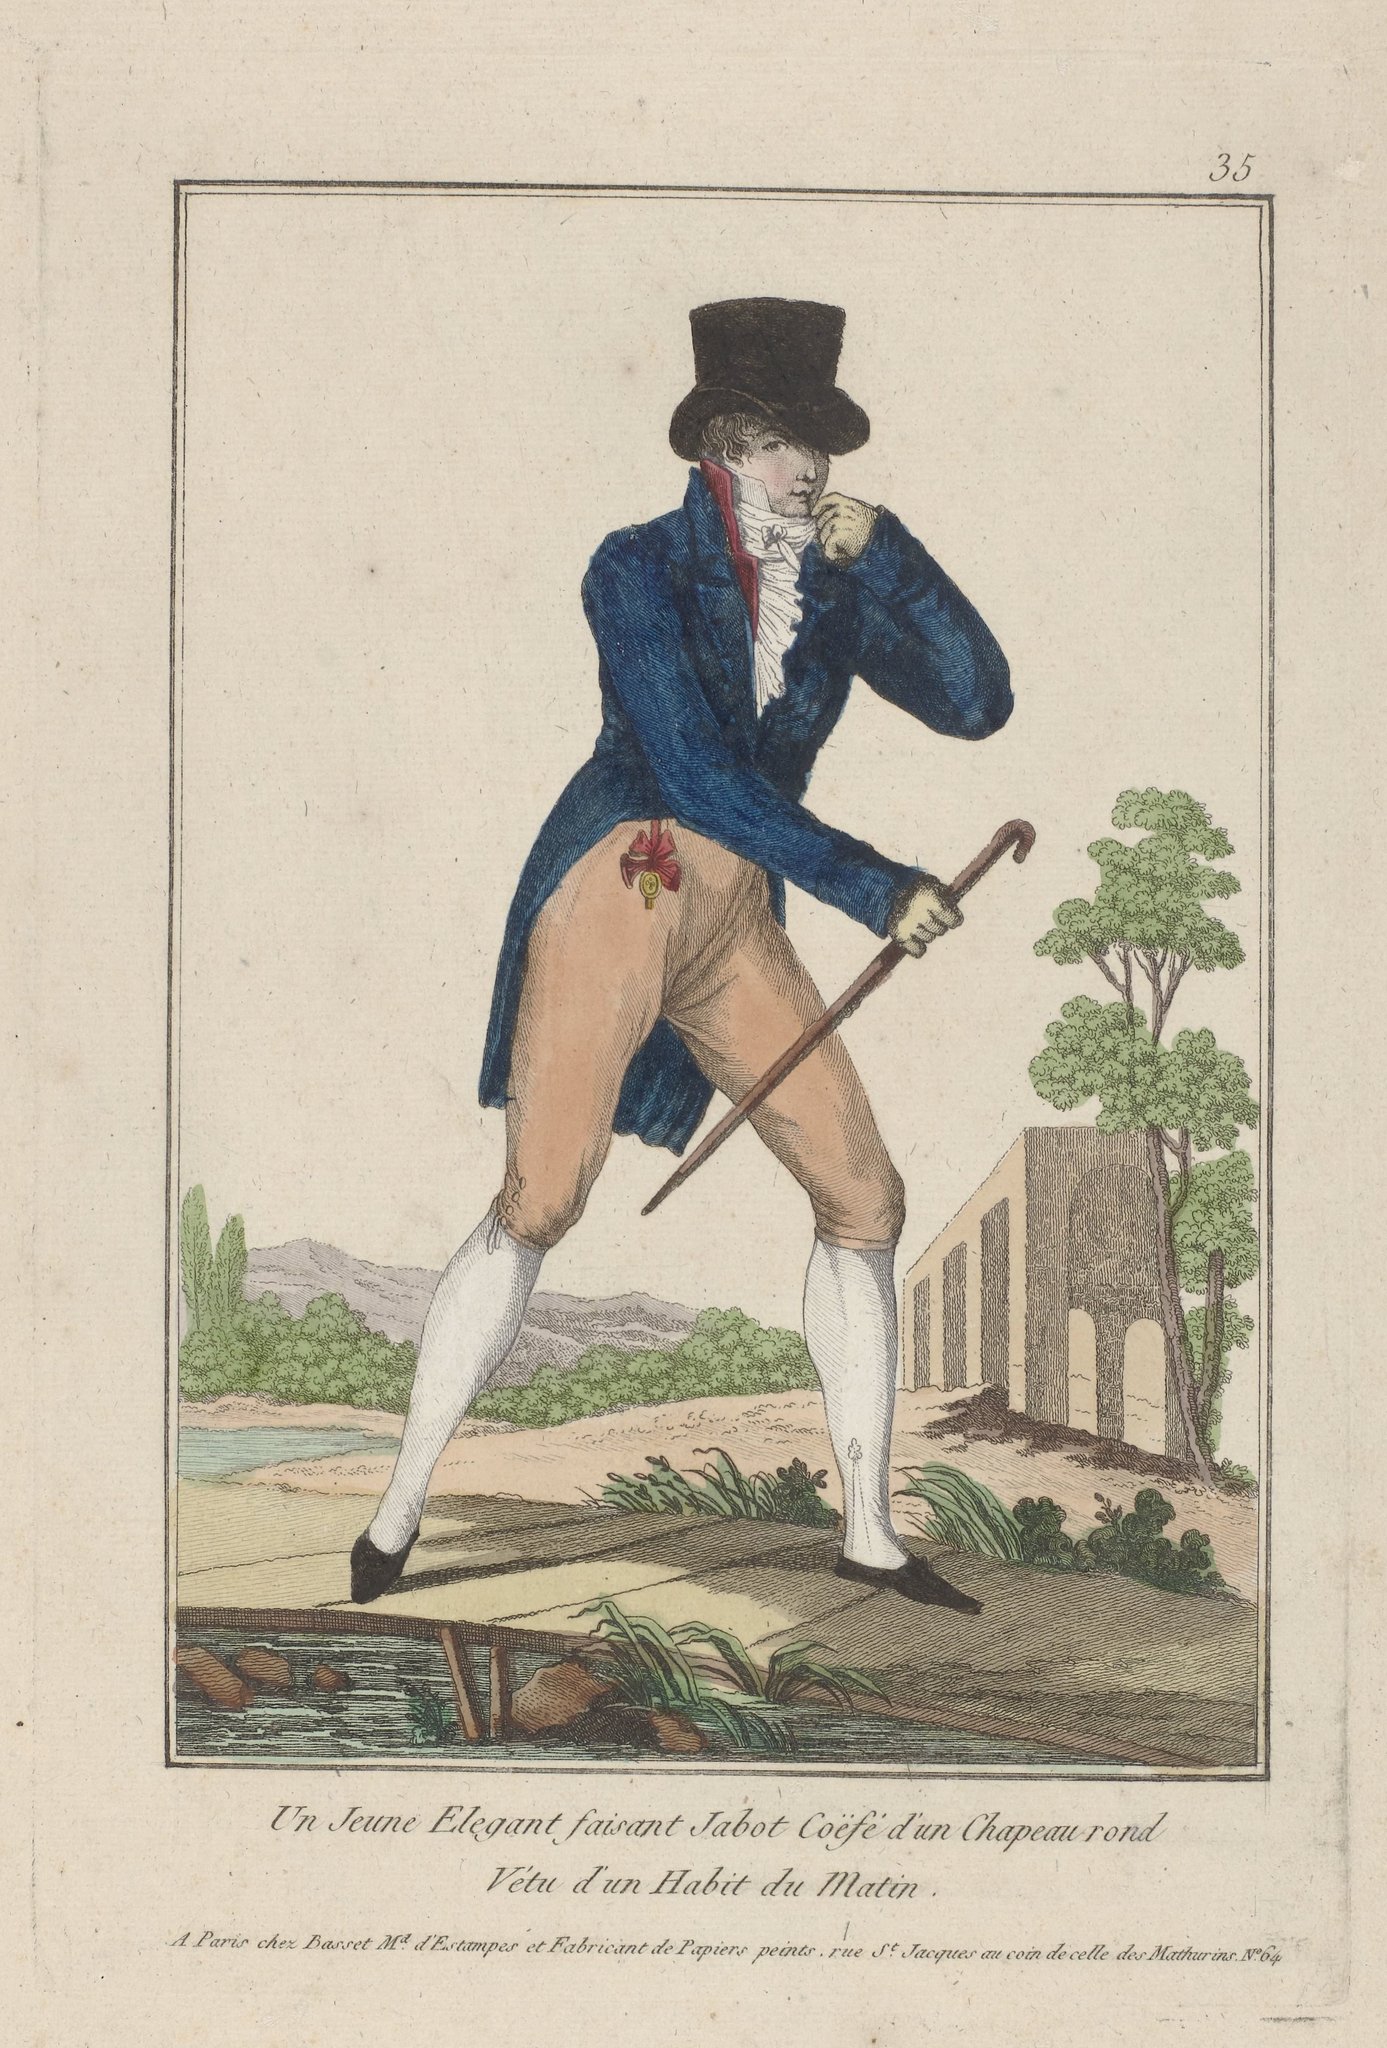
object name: costume print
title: Collection consacrée aux modes d'hommes et de femmes, 1783-1813, No. 35 (181) : Un jeune Elegant faisant Jabot (...)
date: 1783-1813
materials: paper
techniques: engraving, hand coloring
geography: paris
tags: clothing for the upper part of the body (vest) (+ men's clothes), neck-gear ~ clothing (cravat) (+ men's clothes), coat (+ men's clothes), fashion plates, shoes, sandals (+ men's clothes), trousers, breeches, etc. (breeches) (+ men's clothes), gloves, mittens, etc. (+ men's clothes), stockings, socks (+ men's clothes), walking-stick, staff, cane (+ men's clothes)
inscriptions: address: ‘A Paris chez Basset Md d'Estampes et Fabricant de Papiers peints. rue St. Jacques au coin de celle des Mathurins No.64.’, caption: ‘Un jeune Elegant faisant Jabot Coëfé d'un Chapeau rond Vétu d'un Habit du matin.’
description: Jonge elegante man gekleed in een 'habit' voor de ochtend, bestaande uit een jas (frak), vest en kniebroek. Hemd met gerimpelde jabot en cravate. Hoge hoed met opstaande rand en dunne hoedenband met gesp. Handschoenen en wandelstok in de hand. De prent maakt deel uit van een reeks van ten minste 82 modeprenten, Collection consacrée aux Modes d'hommes et de femmes, uitgegeven door Basset, Parijs, tussen 1783 en 1813.